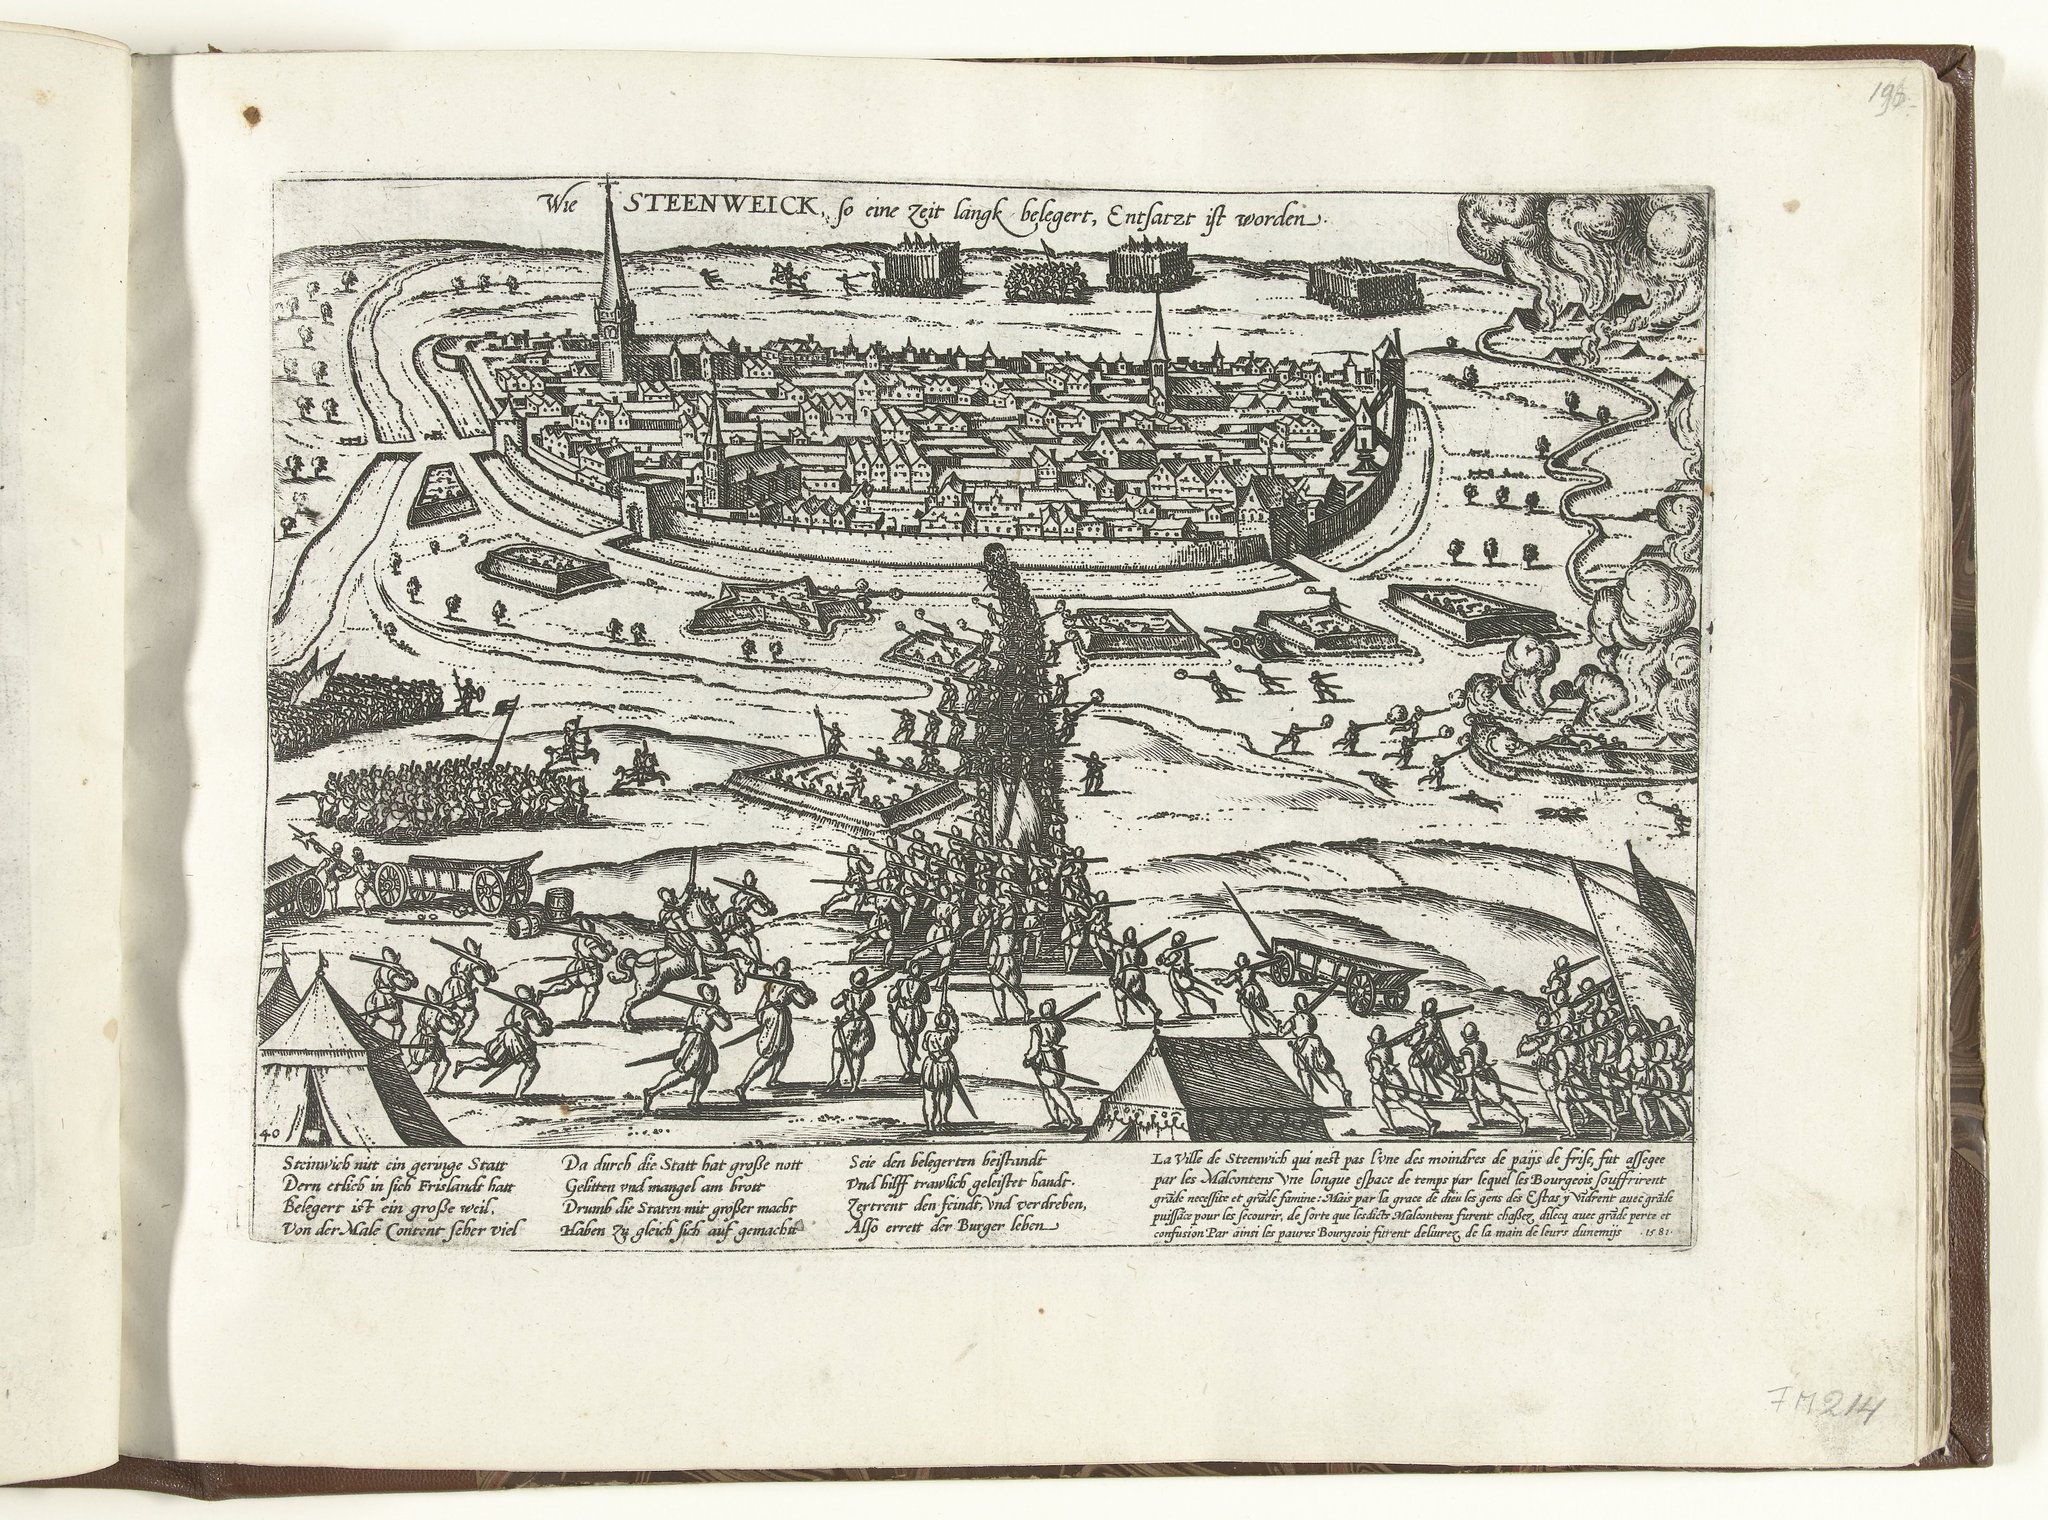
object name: print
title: Ontzet van Steenwijk, 1581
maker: frans hogenberg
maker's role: print maker, publisher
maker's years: 1538-1590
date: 1581-1583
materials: paper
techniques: etching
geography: cologne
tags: kalkar, siege, position war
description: Steenwijk belegerd door de Malcontenten onder Rennenberg en ontzet door het Staatse leger onder Sonoy en Norrits, 22 februari 1581. Met onderschrift van 12 regels in het Duits en 5 regels in het Frans. Genummerd: 40.